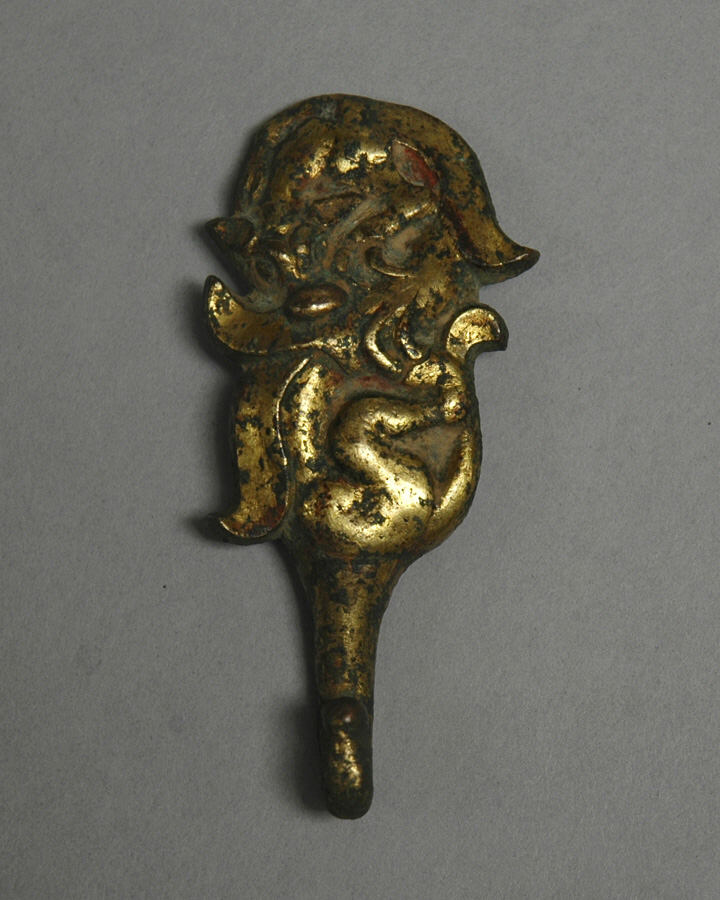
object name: belt hook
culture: chinese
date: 400-201 BCE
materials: gilt bronze